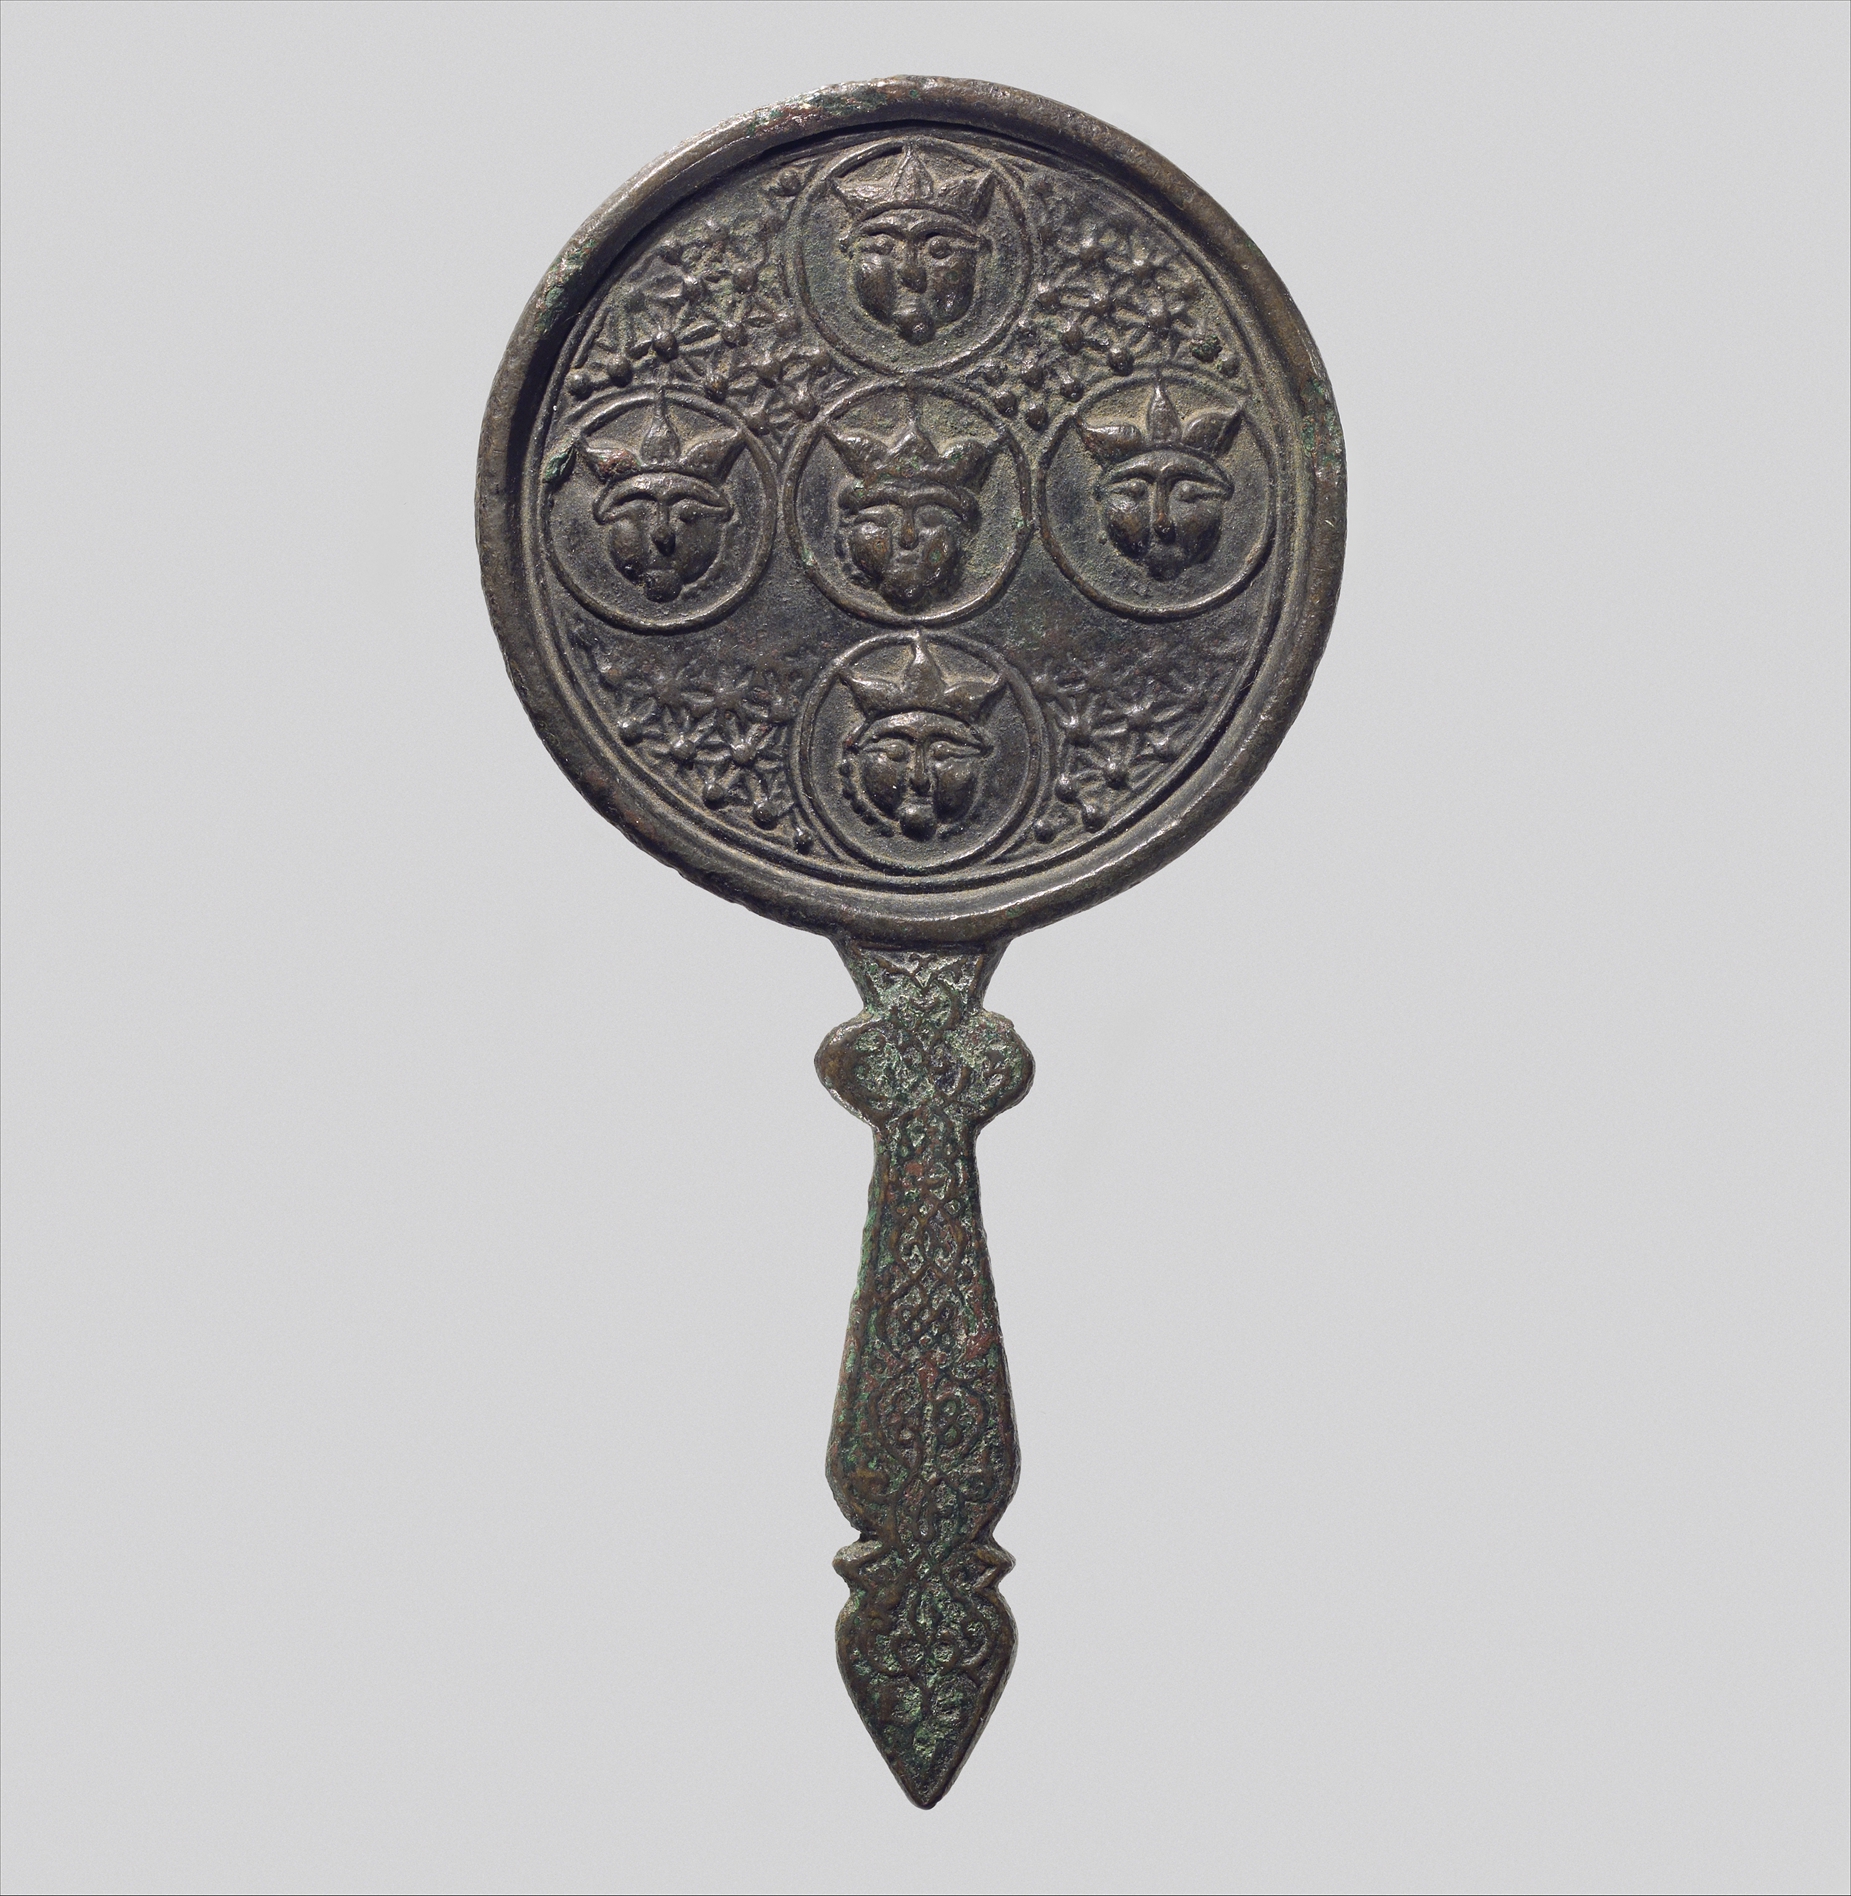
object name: mirror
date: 1201-1300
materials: bronze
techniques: casting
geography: iran